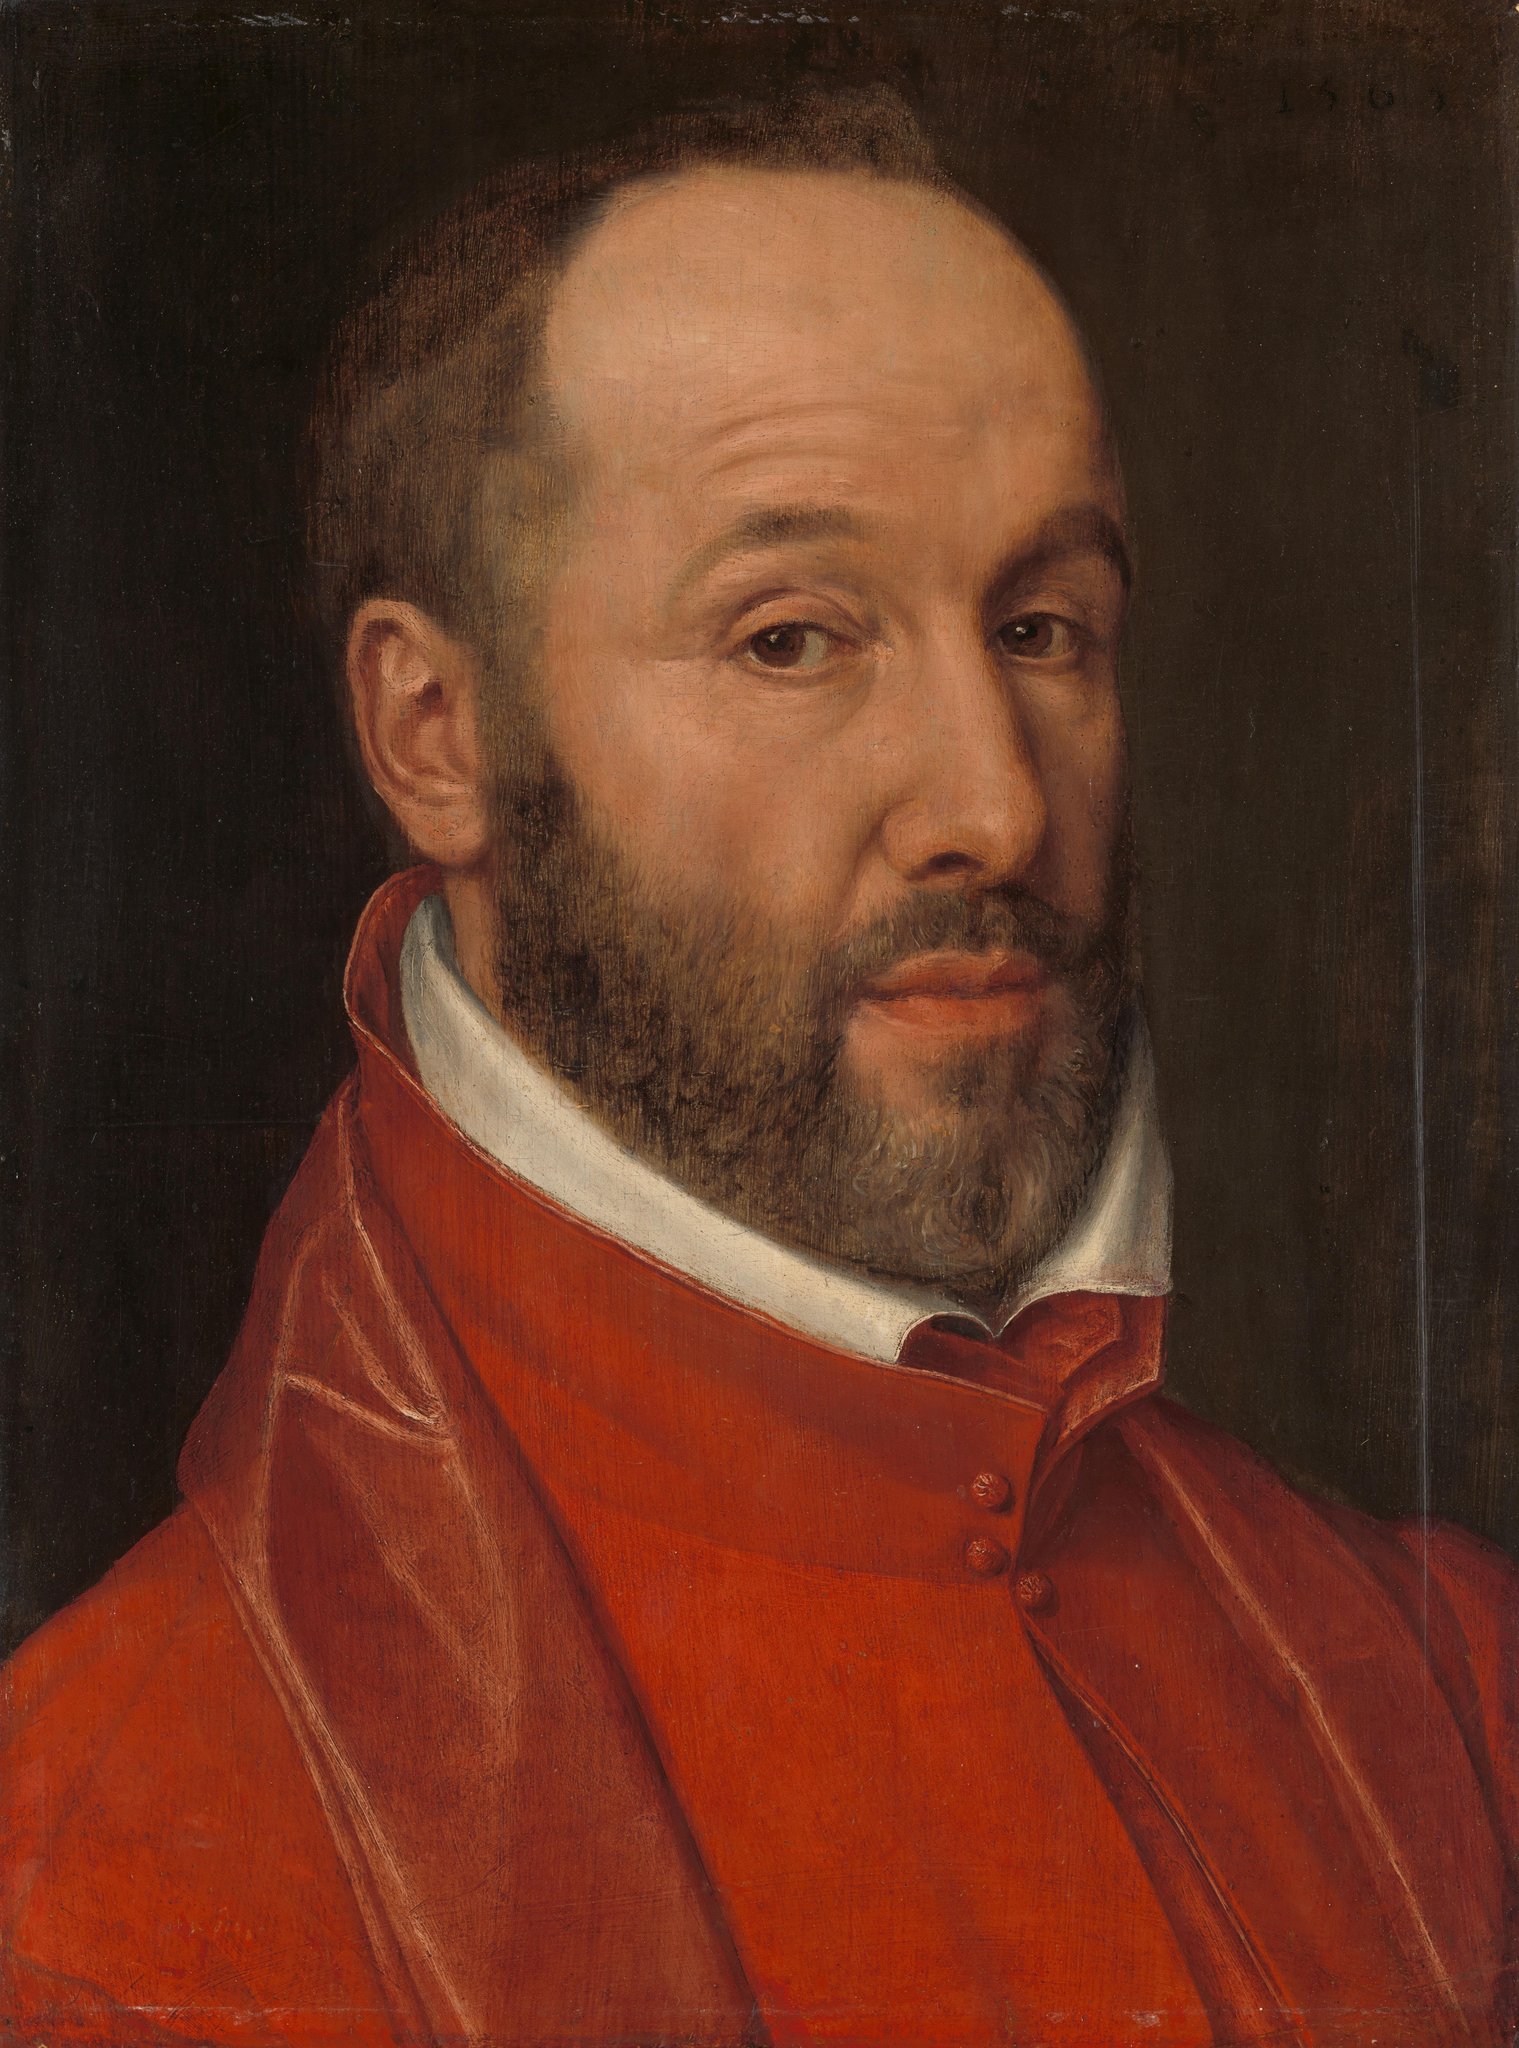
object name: painting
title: Portrait of Antoine Perrenot, Cardinal de Granvelle, Minister to Charles V and Philip II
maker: Anonymous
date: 1565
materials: oil, panel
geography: southern netherlands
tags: philip ii of spain, antoine perrenot de granvelle, ghent, charles v (holy roman emperor and king of spain), netherlands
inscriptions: date: ‘1565’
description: Kardinaal Antoon Perrenot de Granvelle, 1517-1586, raadsheer van landvoogdes Margaretha van Parma, 1559-1564. Vermoedelijk oude copie naar een verloren origineel door Willem Key. Gedateerd 1565. Granvelle werd in 1538 benoemd tot Bisschop van Atrecht; in 1550 nam hij de diplomatieke functies in dienst van het Habsburgse hof over van zijn vader. Hij was de voornaamste adviseur van de landvoogdes, sinds 1561 als kardinaal-aartsbisschop van Mechelen bovendien de invloedrijkste kerkelijke autoriteit.